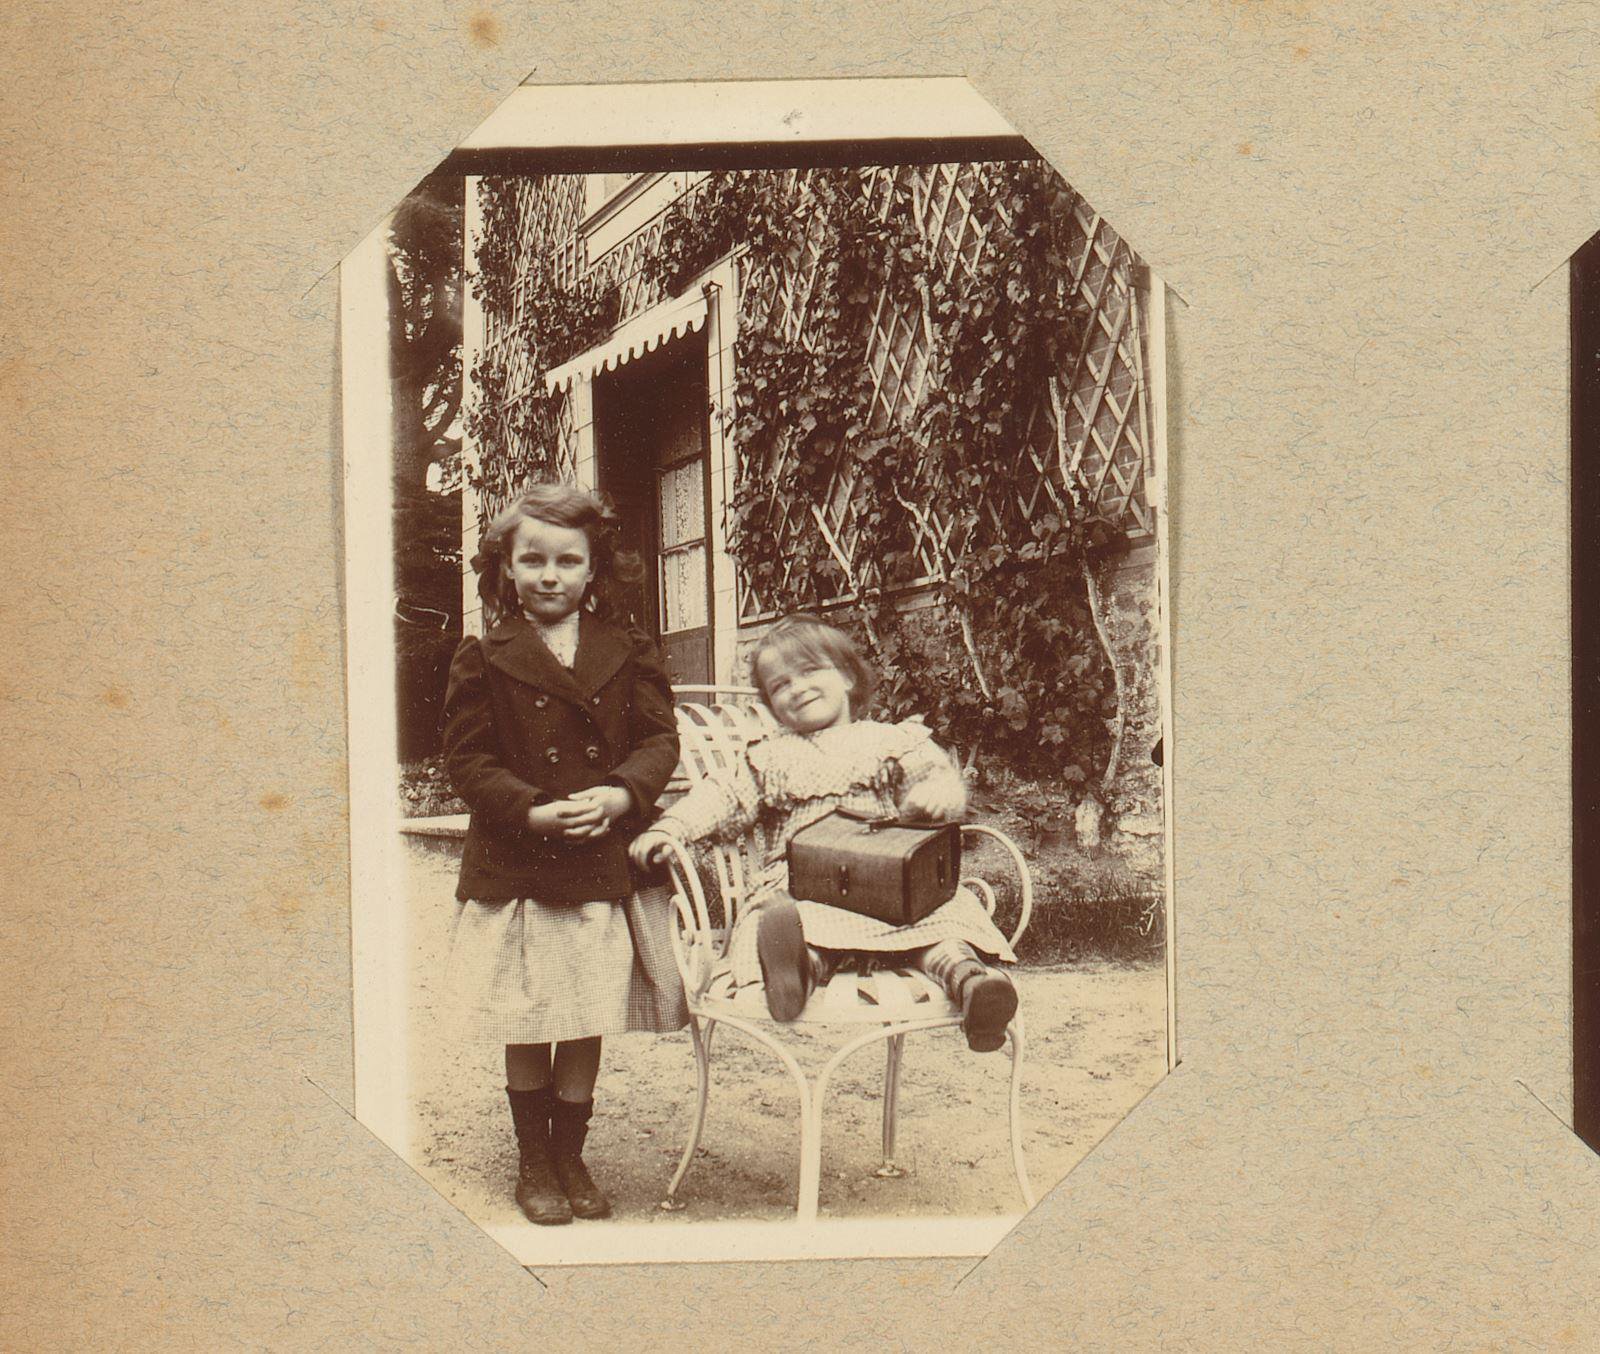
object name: photograph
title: Portret van twee meisjes in een tuin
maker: Anonymous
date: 1897-1900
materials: paper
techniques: gelatin silver print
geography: france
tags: garden, historical persons, girl (child between toddler and youth), france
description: Over de foto is een ander negatief afgedrukt van een voorstelling van bomen.